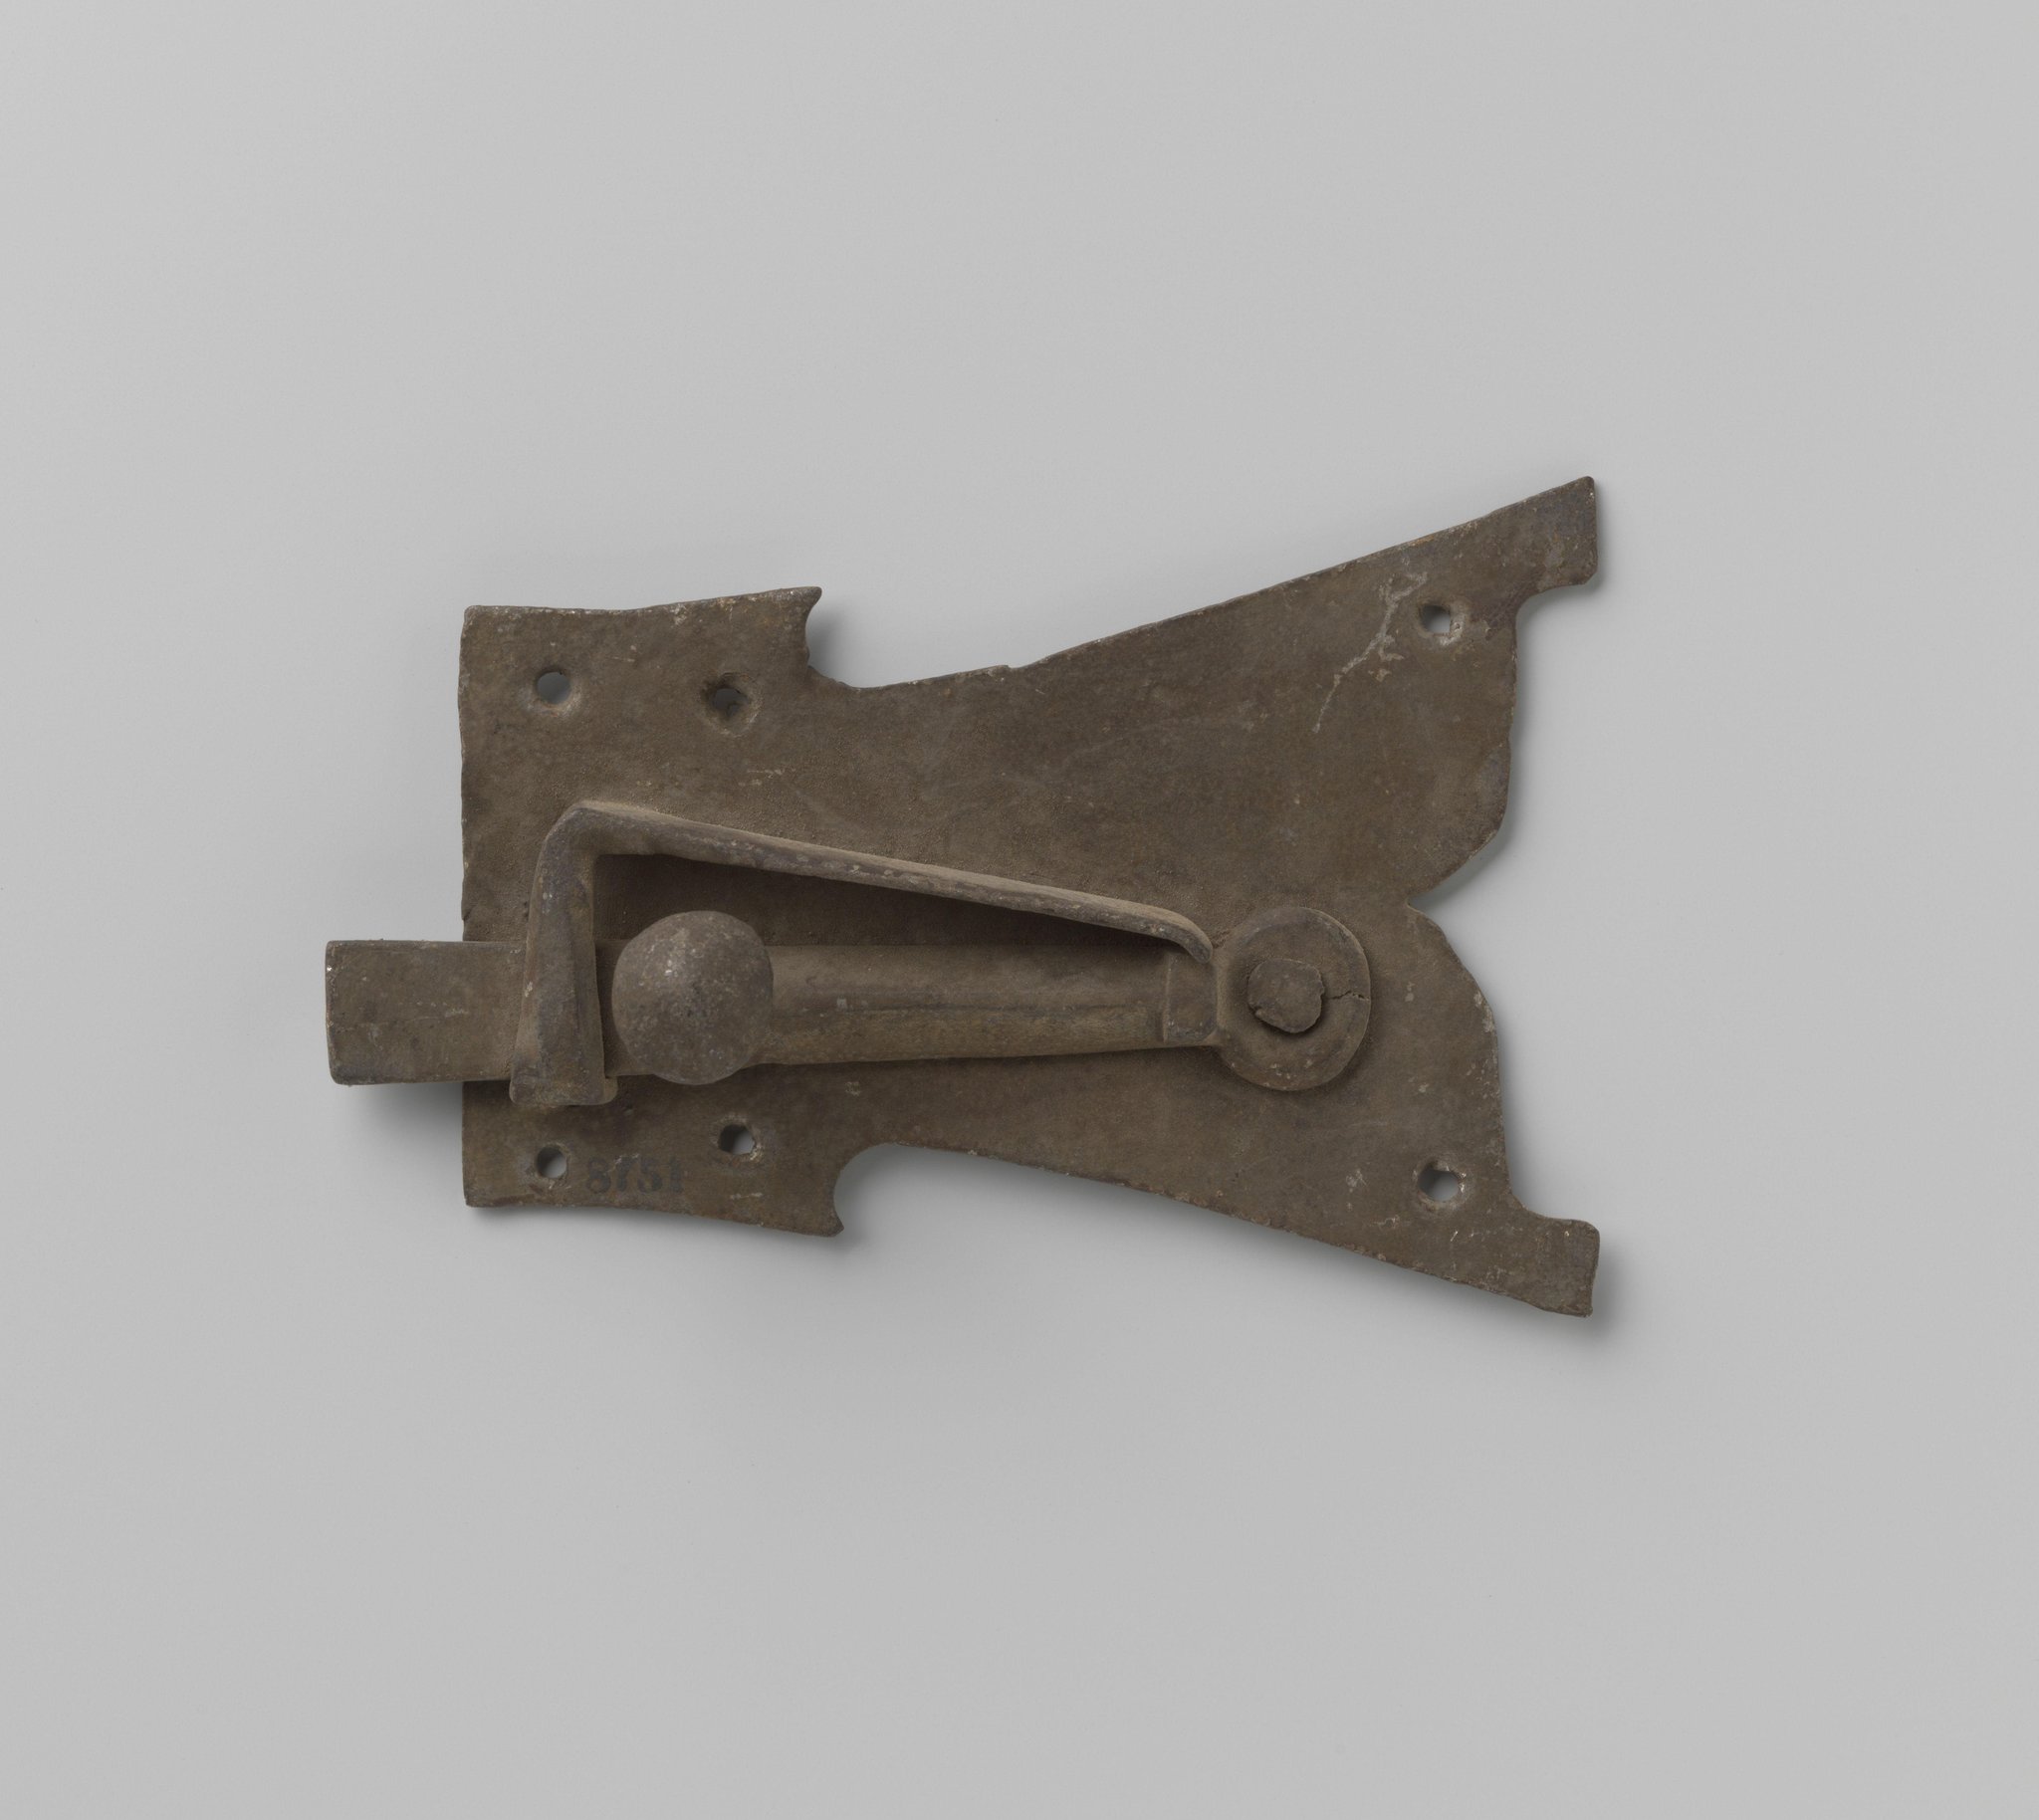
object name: knip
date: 1400-1950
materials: iron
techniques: tinning